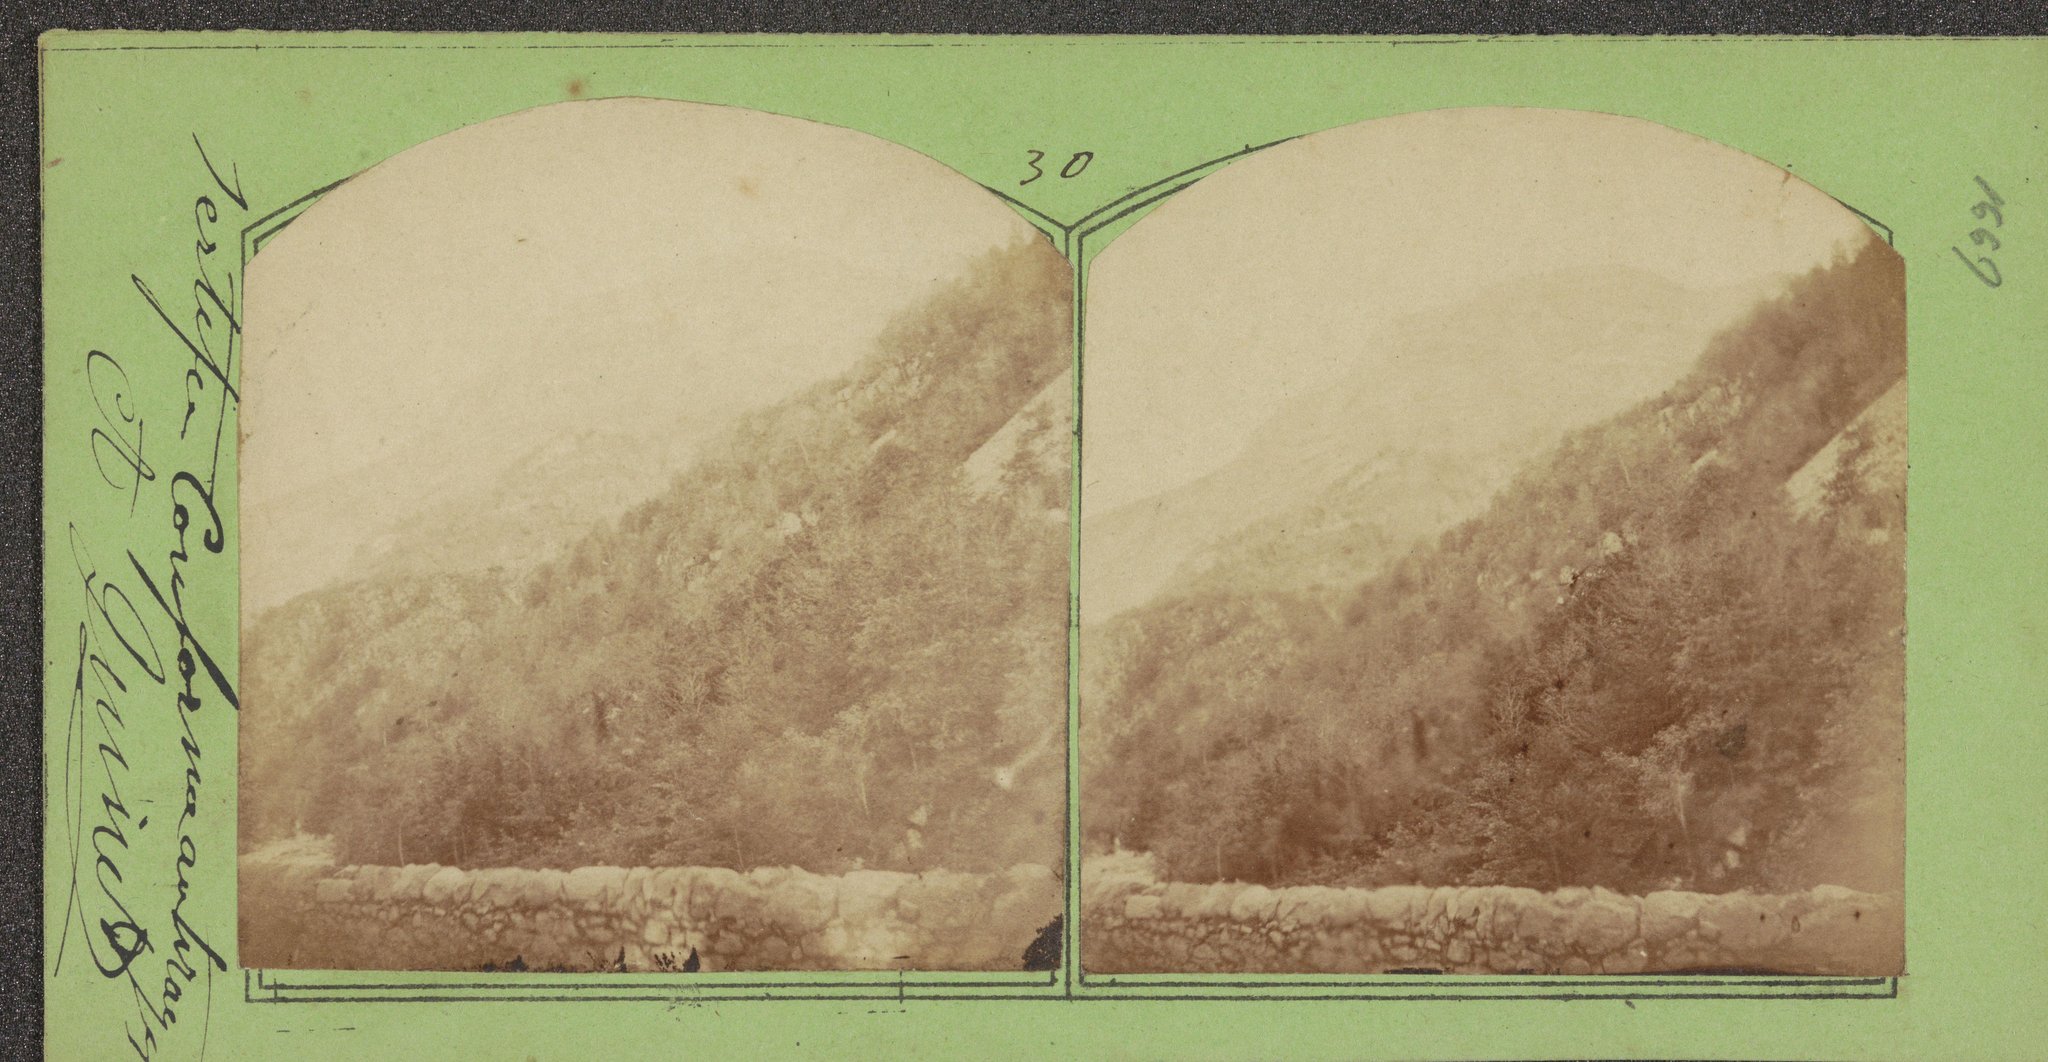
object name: stereograph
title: Met bomen begroeid berglandschap, met een muurtje daarvoor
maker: achille quinet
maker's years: 1831-1900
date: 1860-1880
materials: cardboard, paper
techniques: albumen print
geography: alps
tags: mountains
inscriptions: signature: ‘Sertifier conforme au tirages // A Quinet’